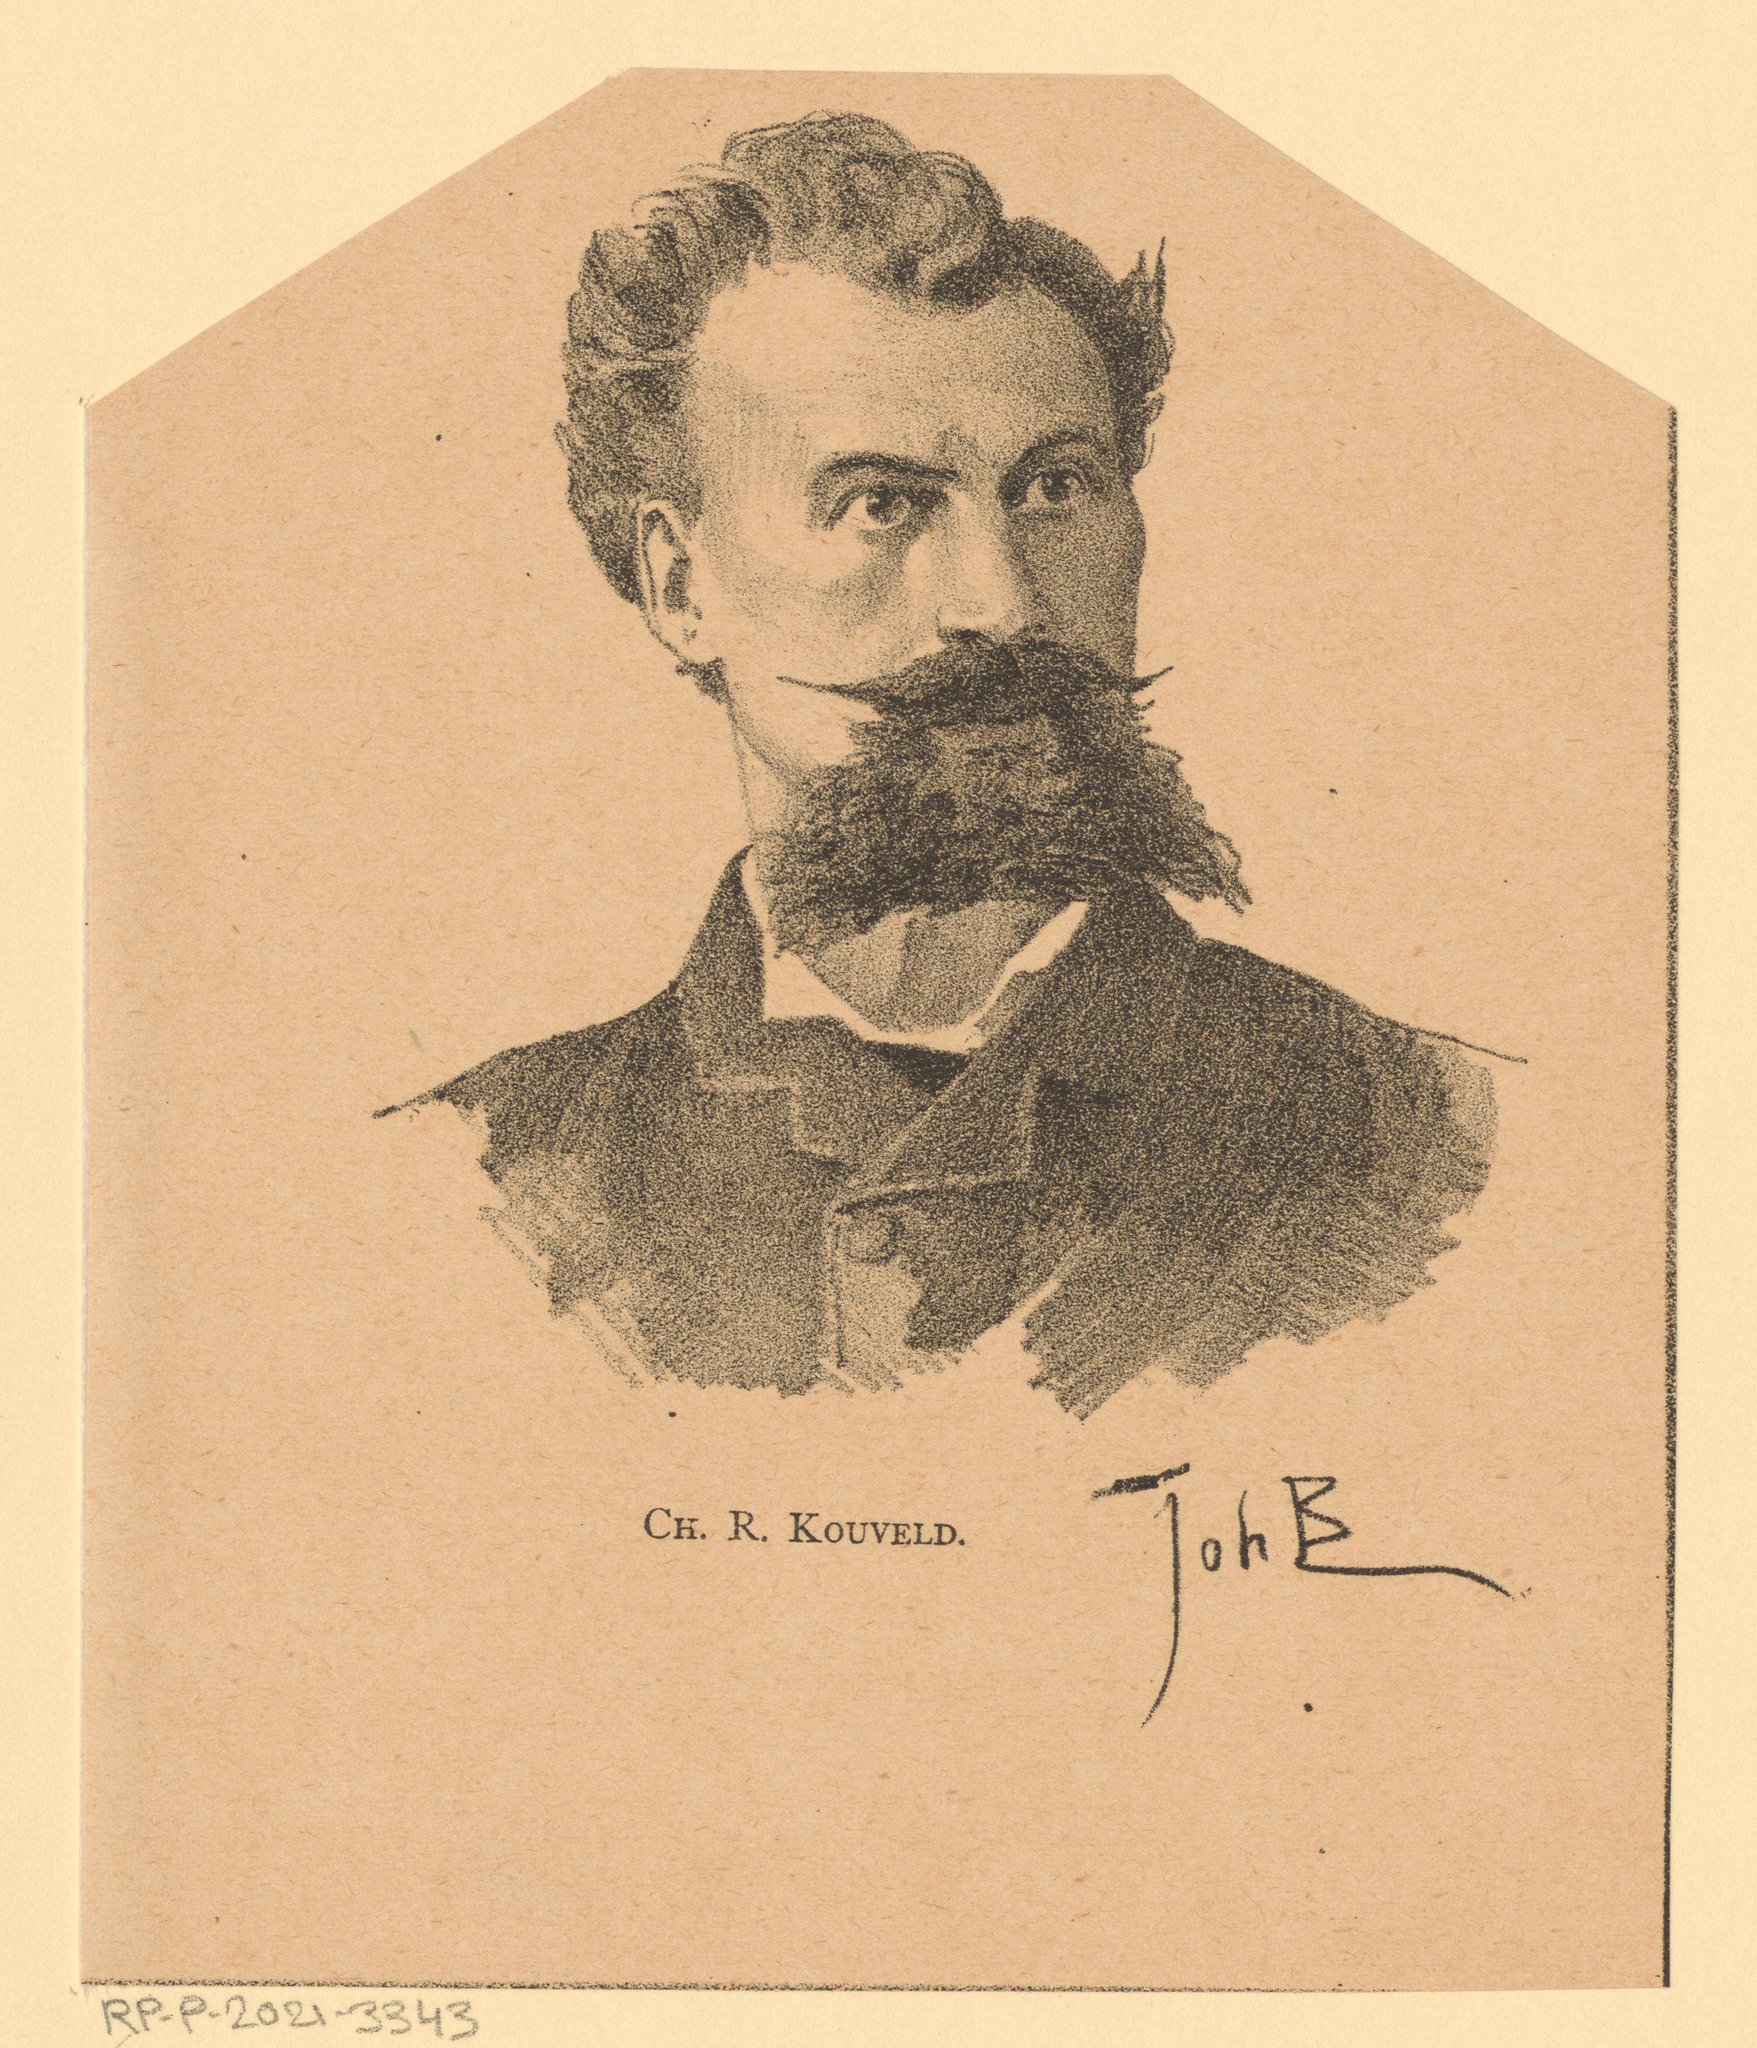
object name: print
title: Het bestuur der Kiesvereeniging "Amsterdam".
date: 1888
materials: paper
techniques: lithograph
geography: amsterdam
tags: historical persons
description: Prent geknipt uit een groter blad met 5 portretten. Prent is het bijvoegsel van: De Amsterdammer. Weekblad voor Nederland, 12 februari 1888.